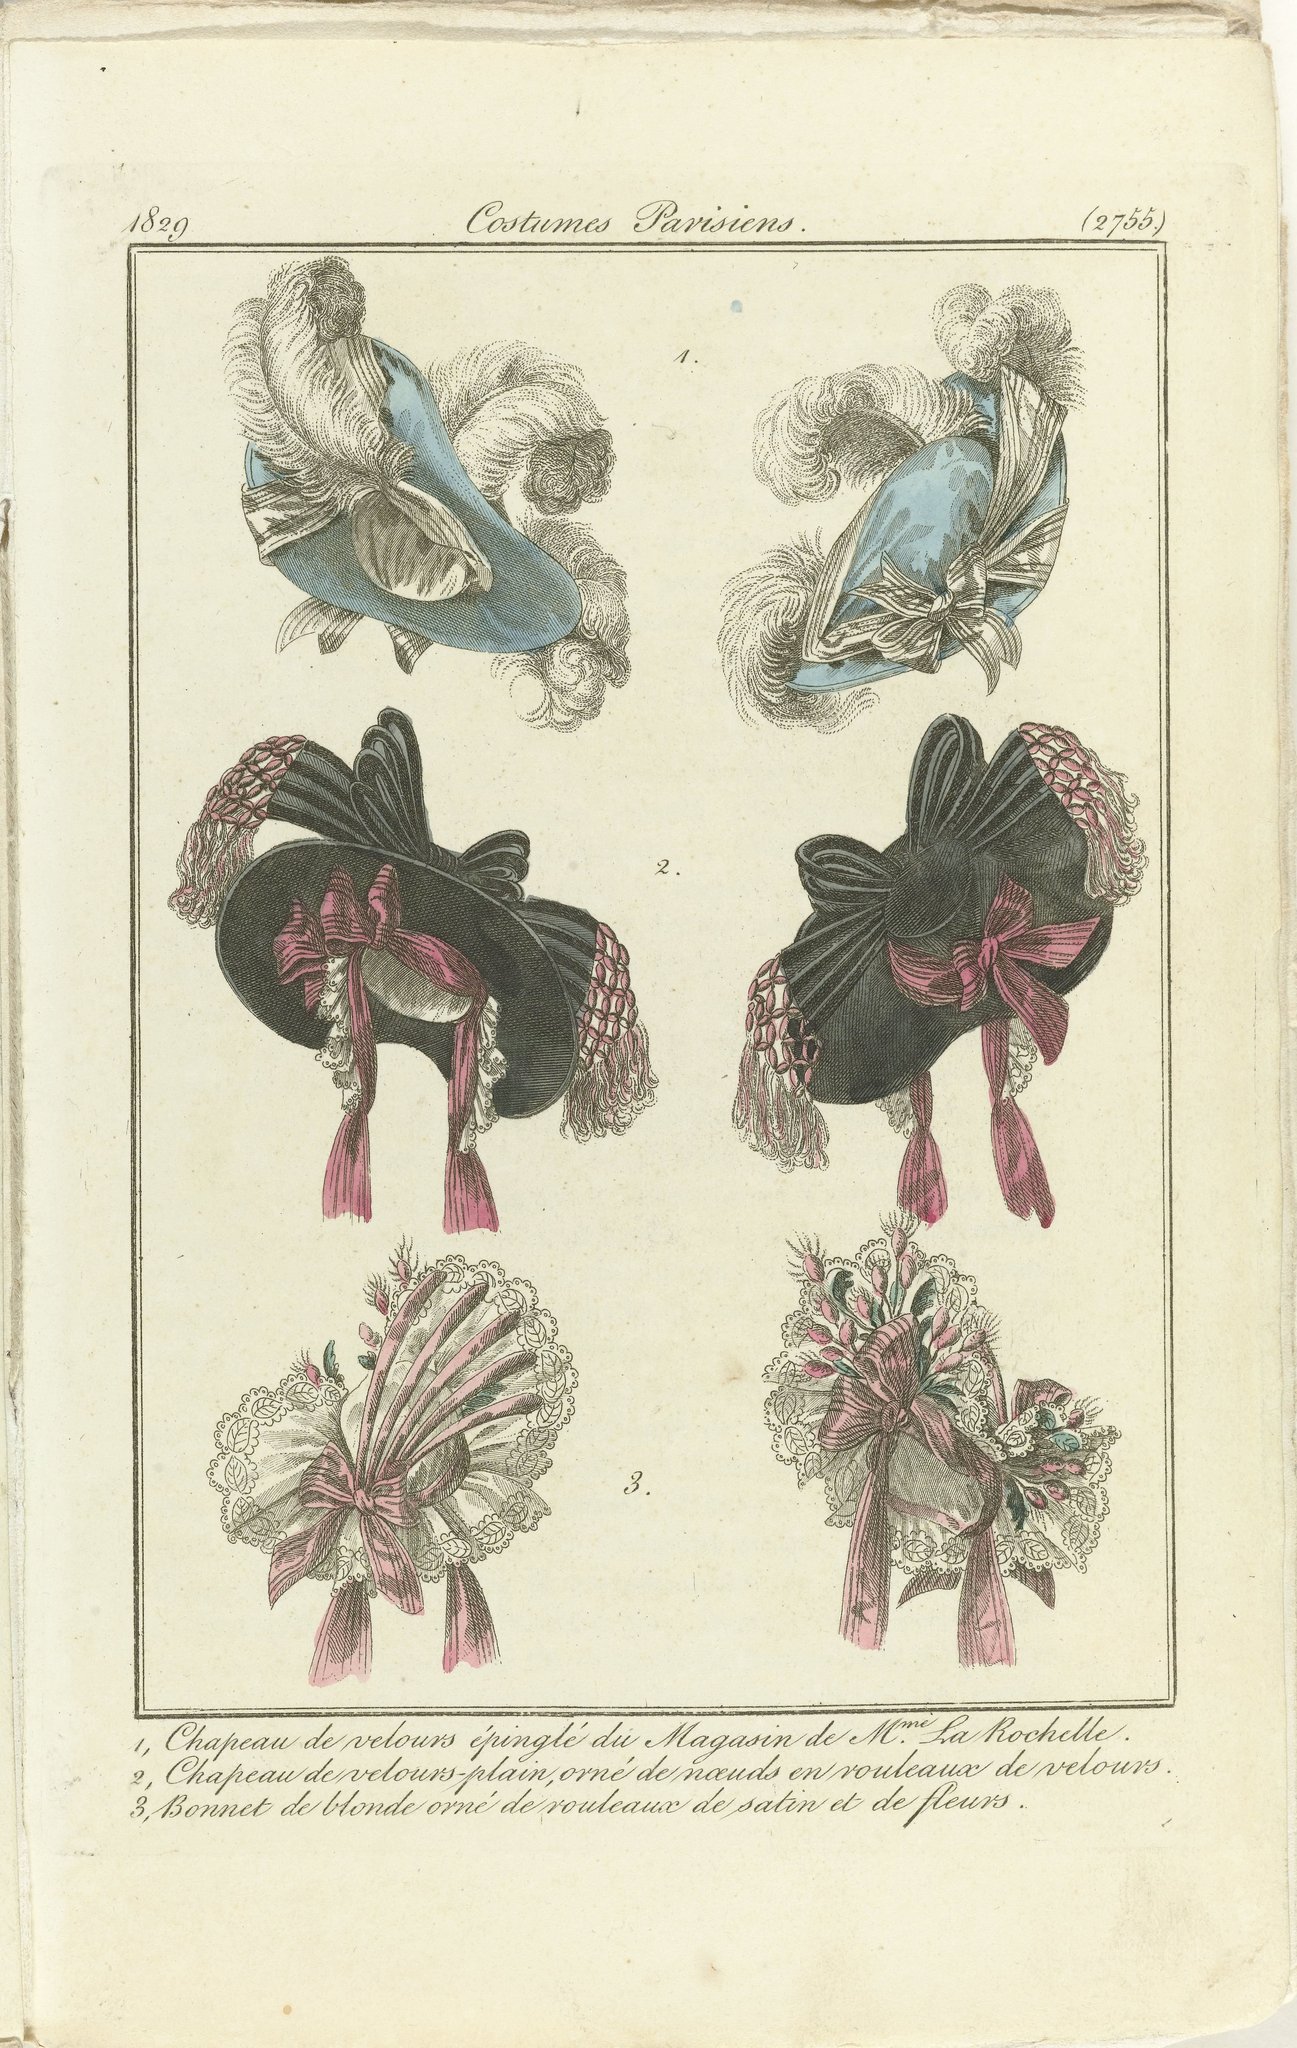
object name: fashion print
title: Journal des Dames et des Modes 1829, Costumes Parisiens (2755)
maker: Anonymous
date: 1829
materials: paper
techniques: etching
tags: fashion plates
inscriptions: date